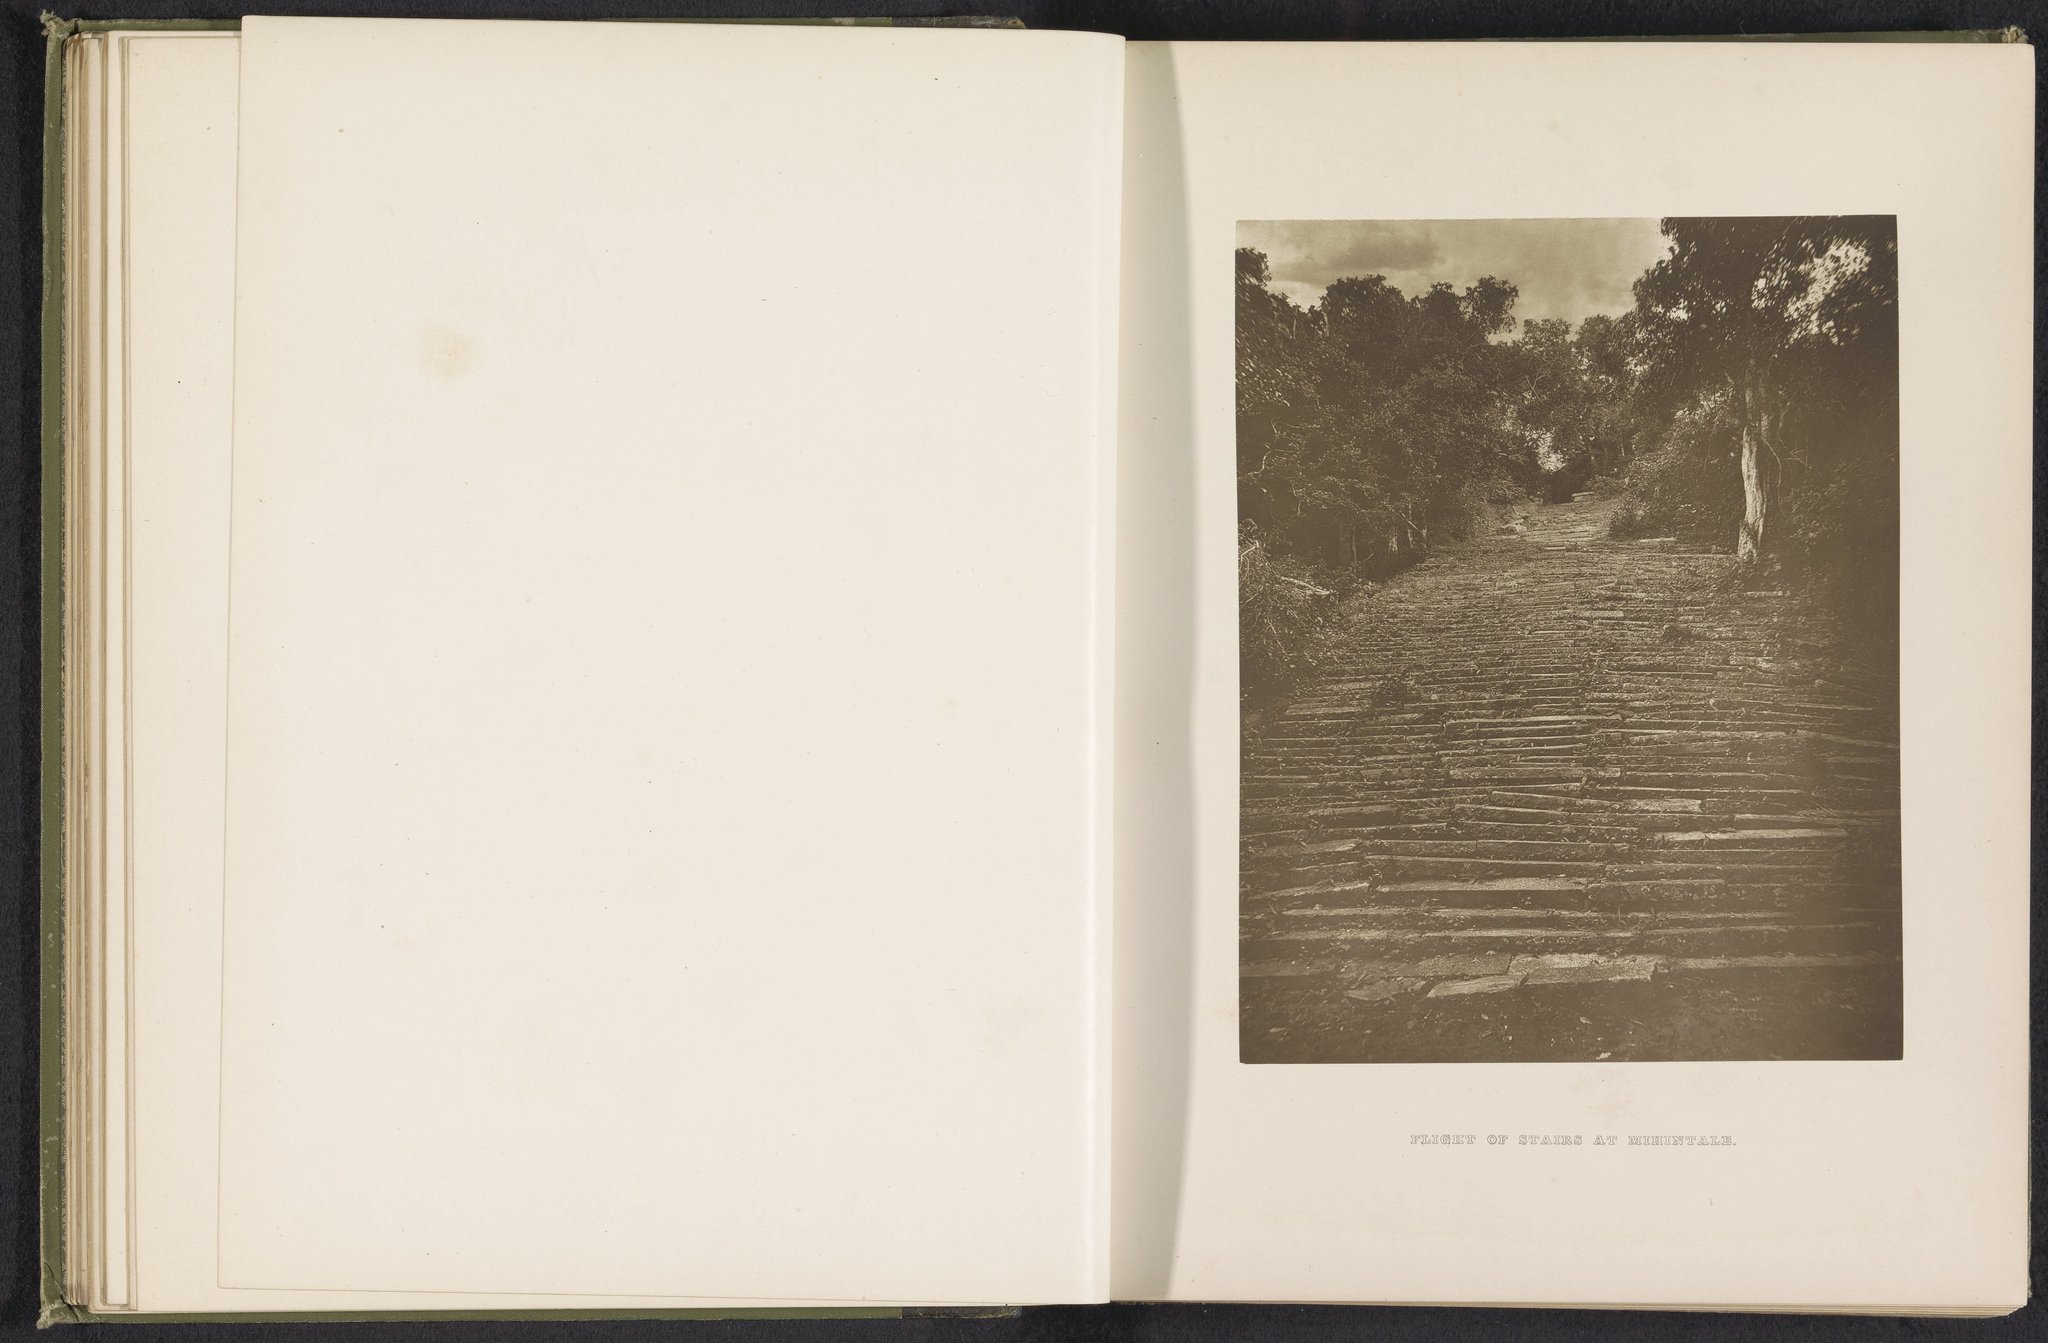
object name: photomechanical print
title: Flight of stairs at Mihintale, Sri Lanka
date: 1896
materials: paper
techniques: woodburygravure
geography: mihintale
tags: flight of steps, mountains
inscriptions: title: ‘FLIGHT OF STAIRS AT MIHINTALE.’